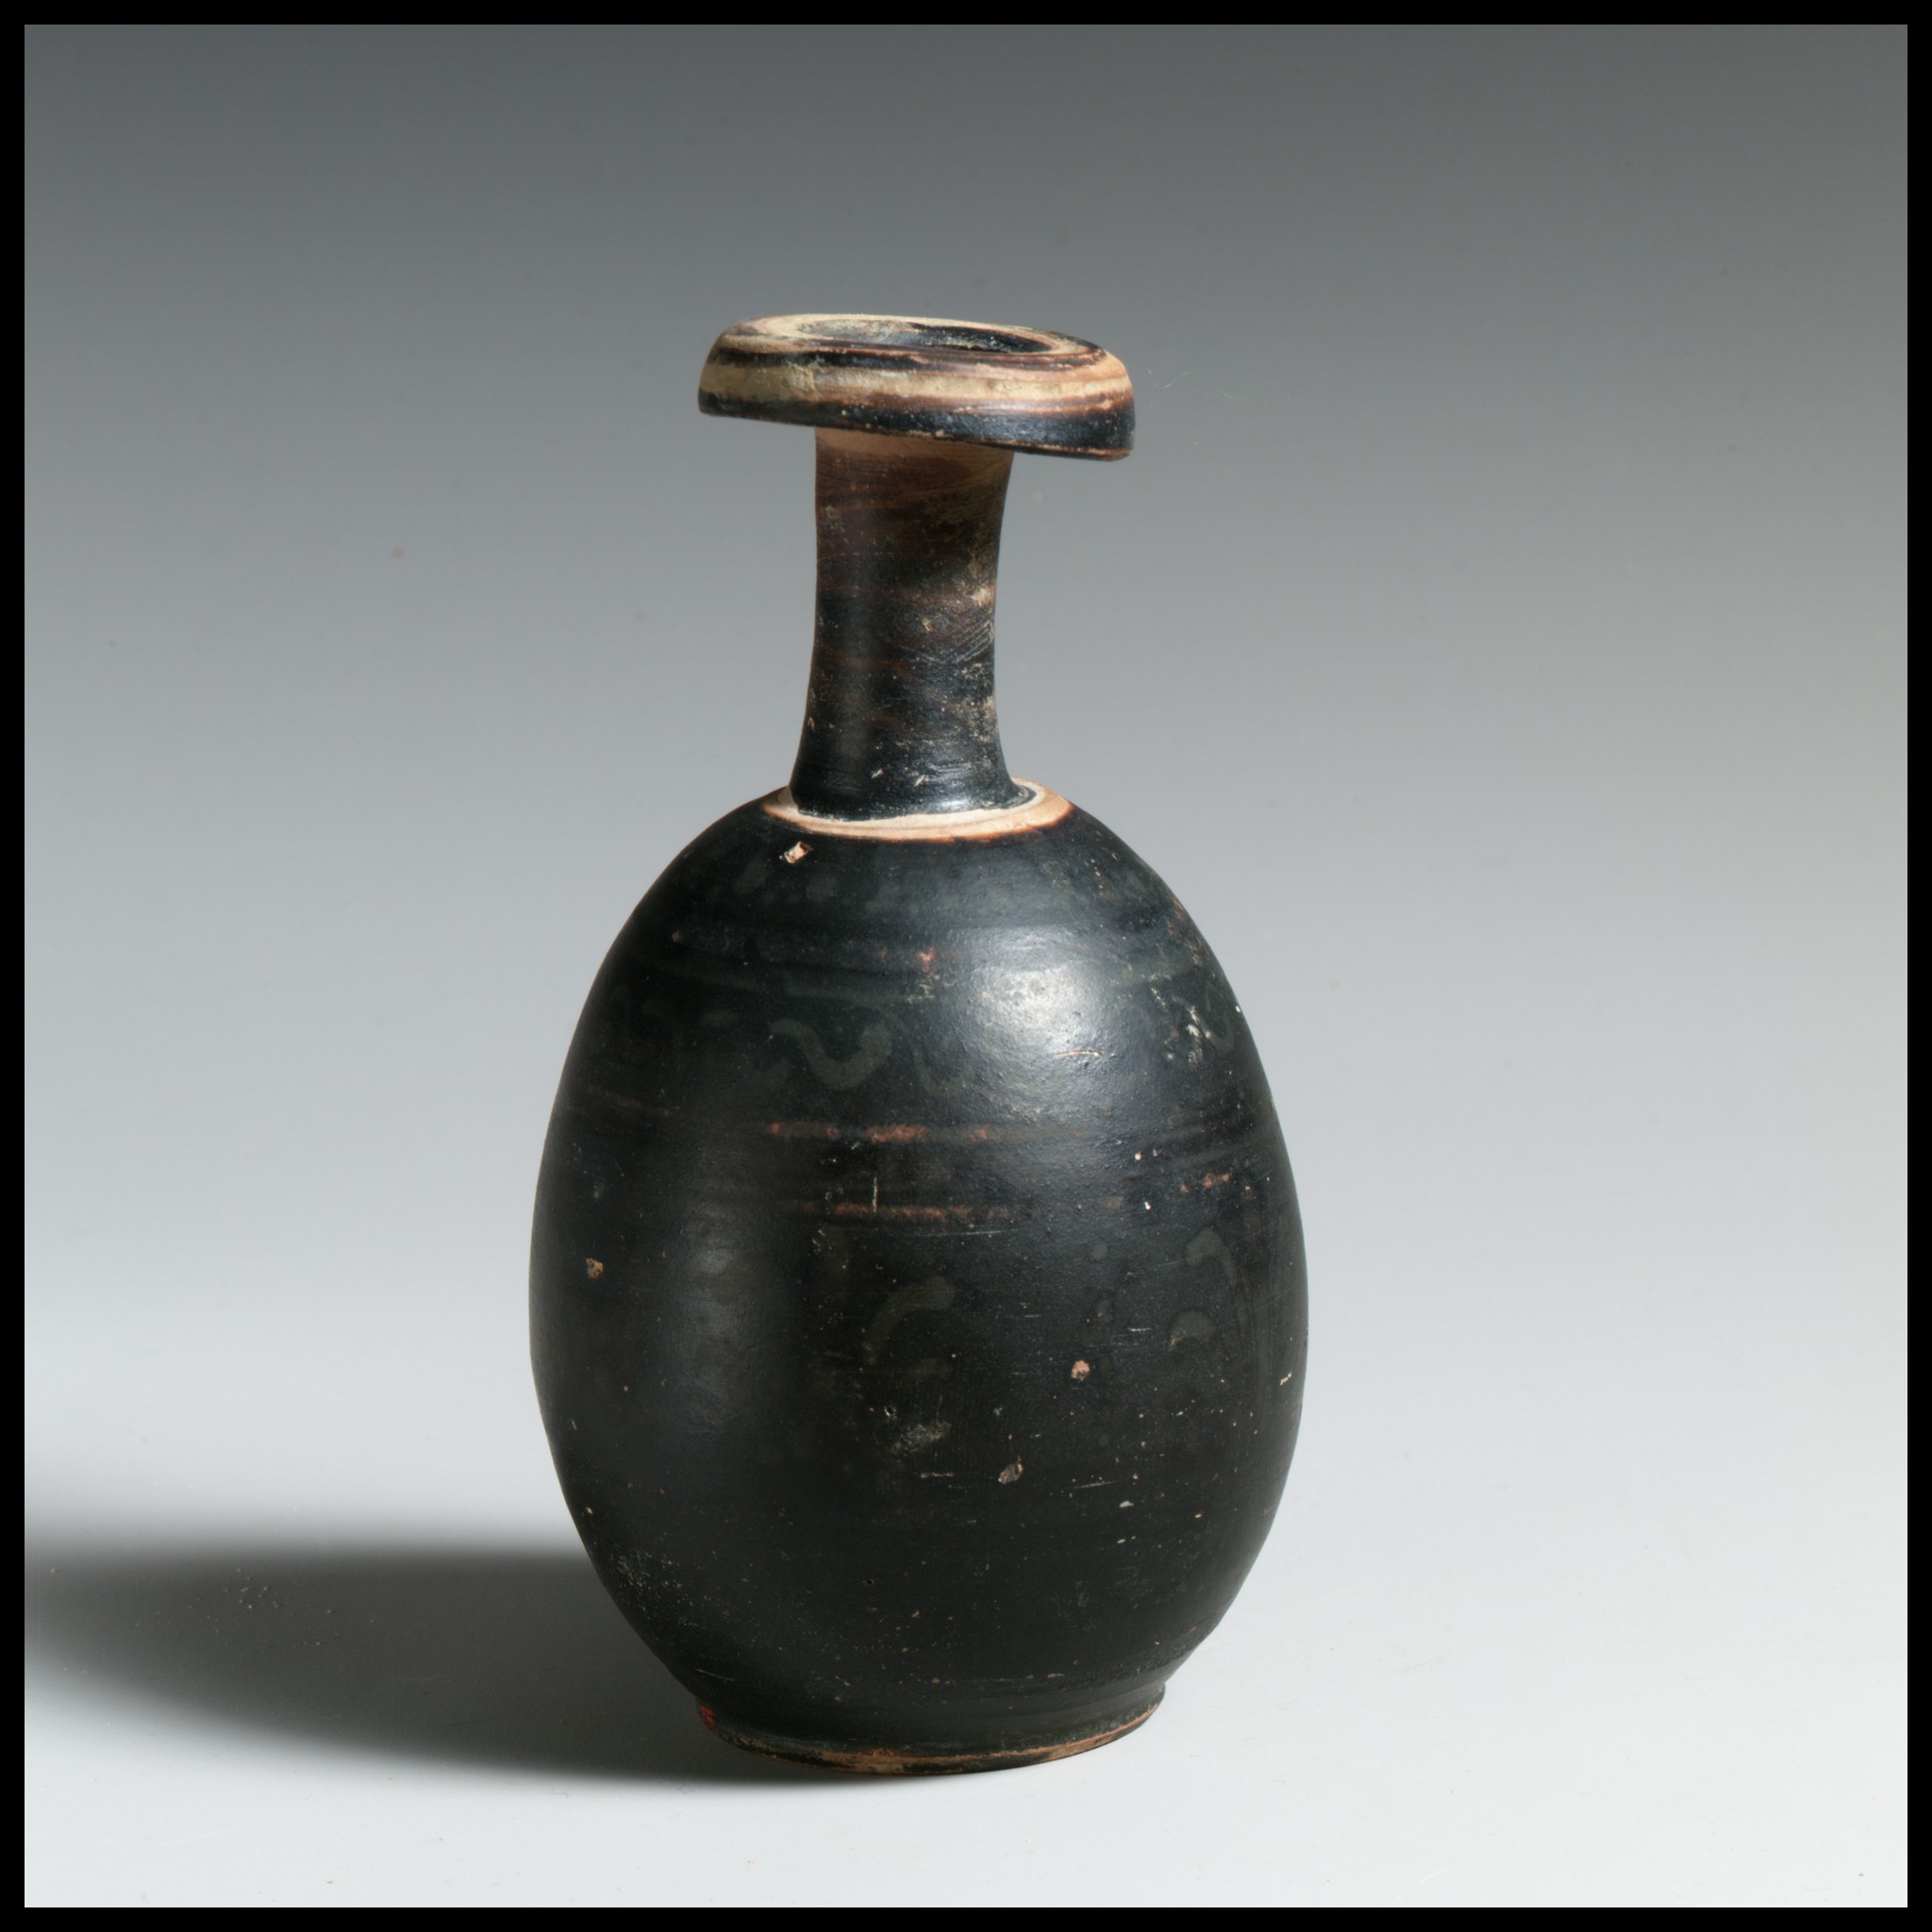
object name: bottle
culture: greek or south italian or campanian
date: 334-301 BCE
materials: terracotta